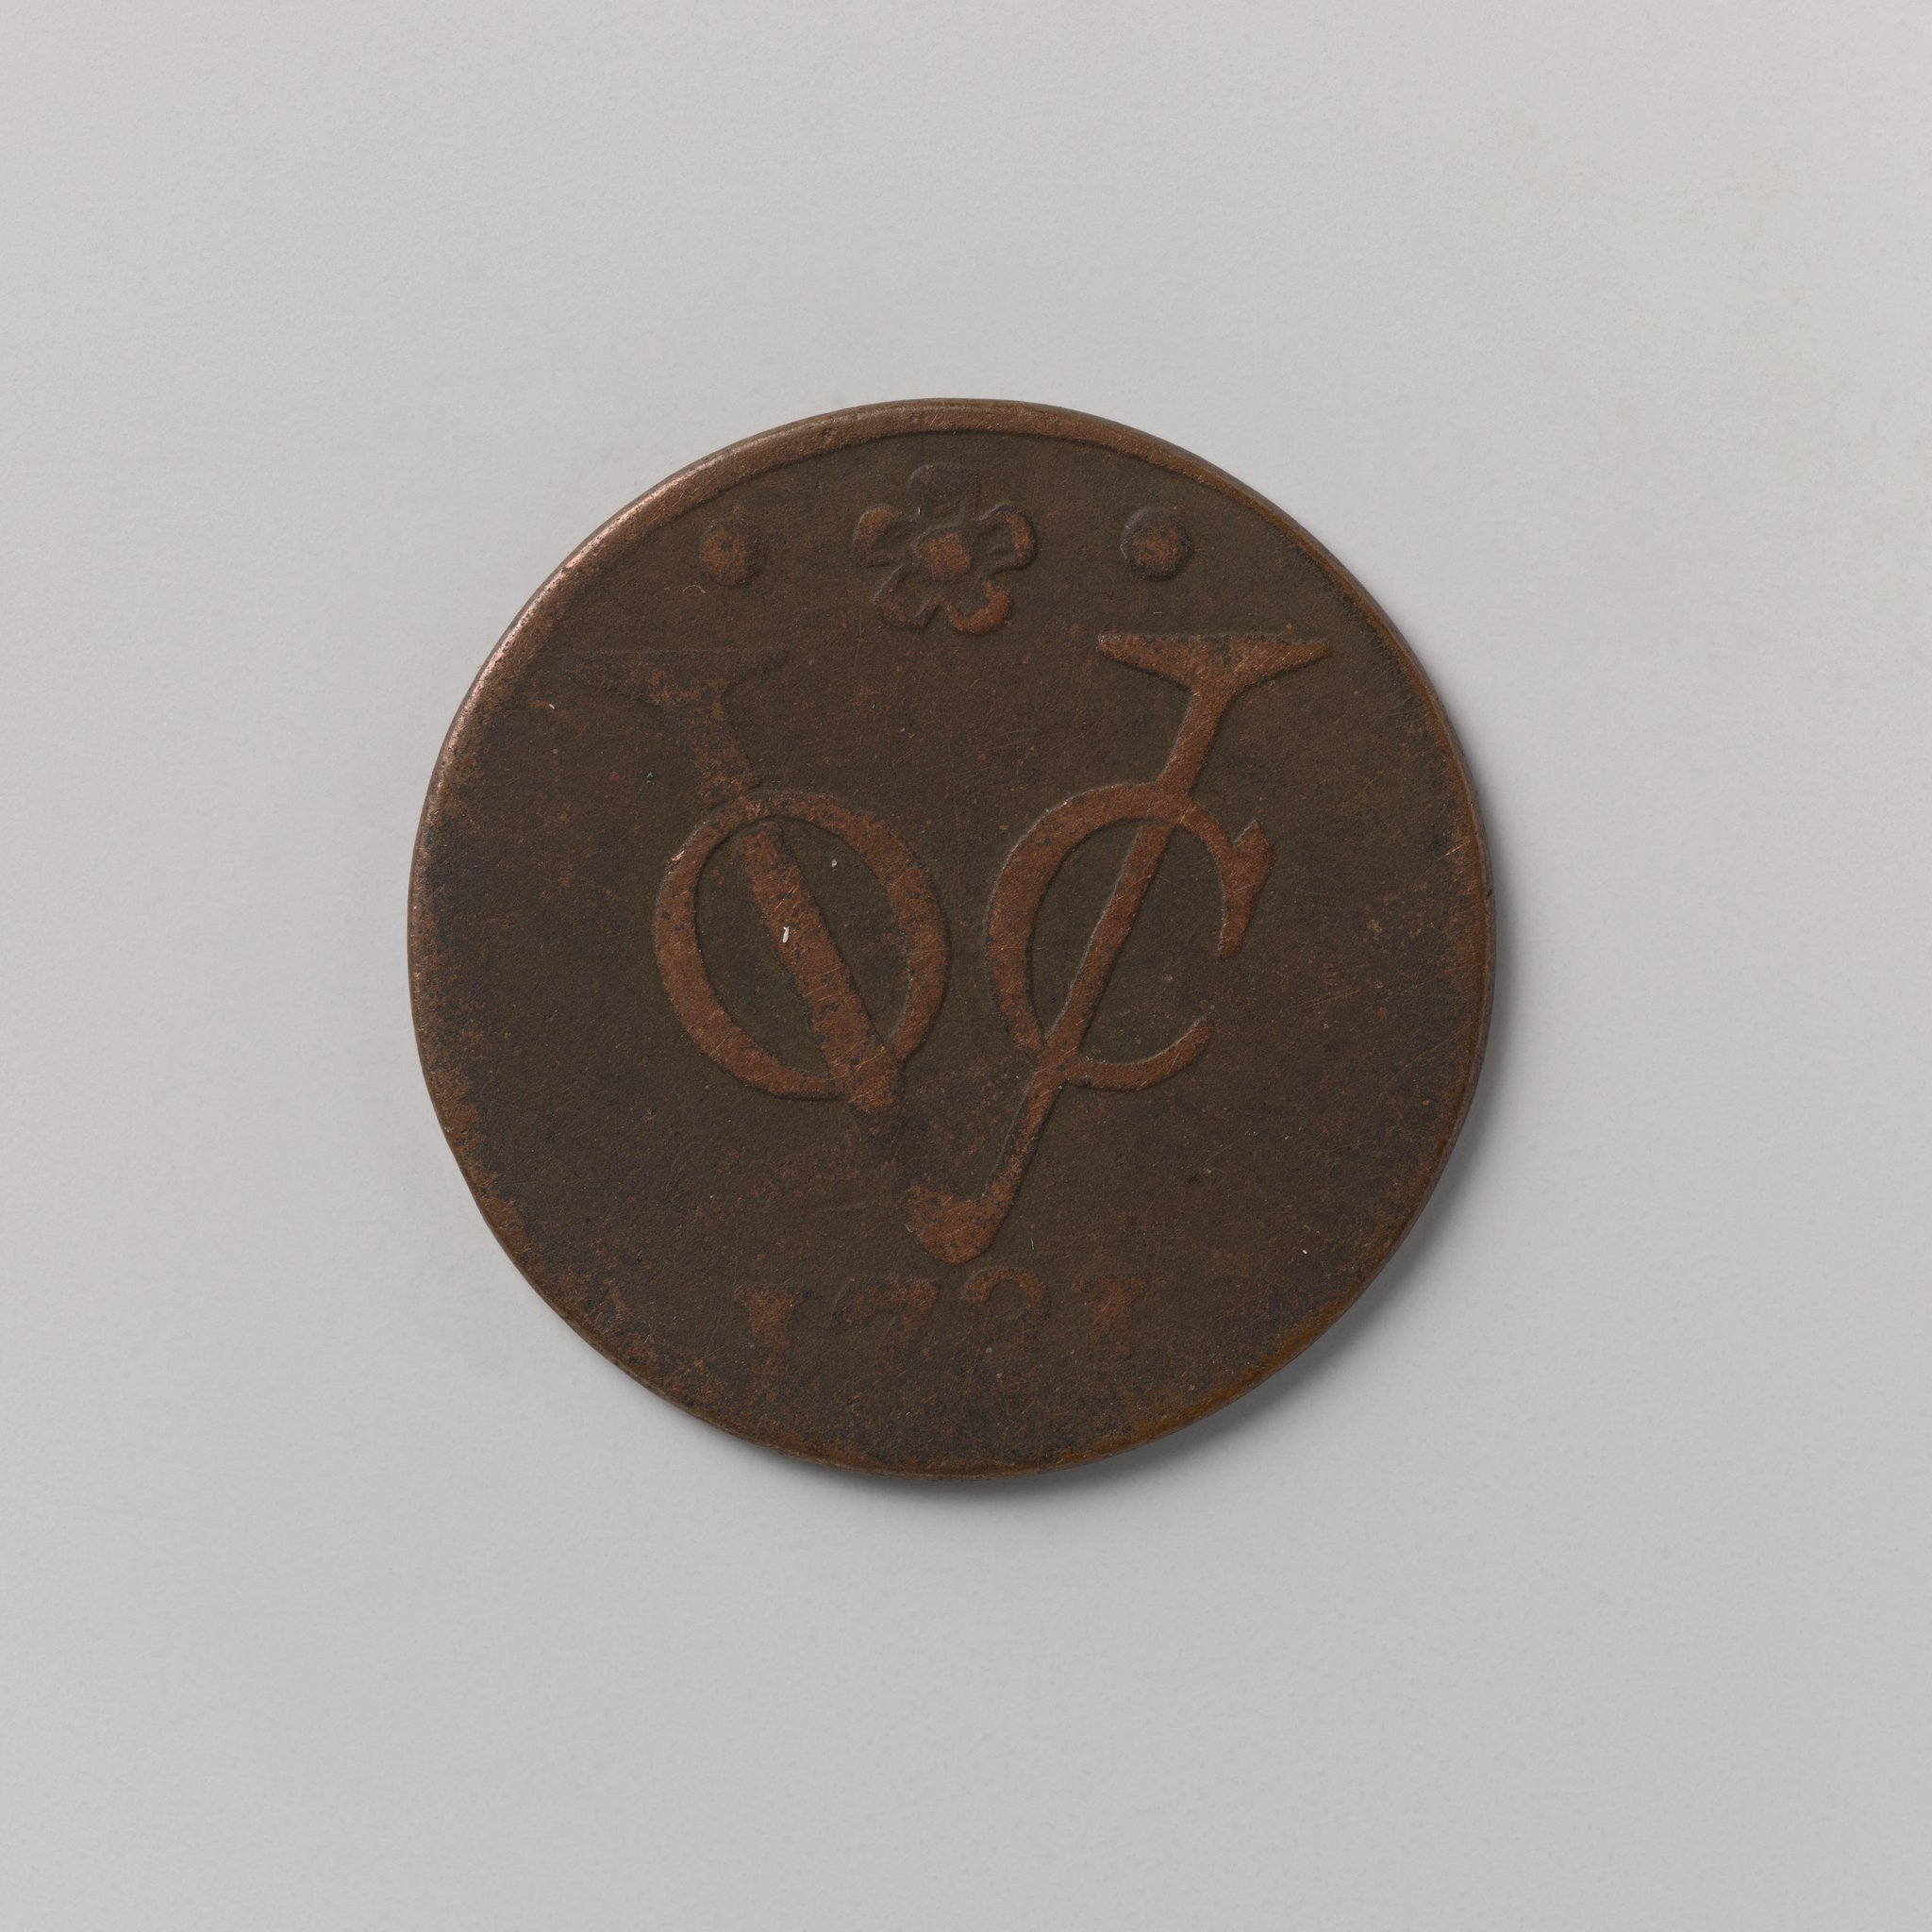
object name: coin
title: Duit van de VOC uit Holland, 1781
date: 1781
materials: copper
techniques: striking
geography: dordrecht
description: Koperen munt. Voorzijde: gekroond wapenschild van Holland. Keerzijde: monogram van de VOC, waarboven muntteken en waaronder jaartal. Gladde rand.